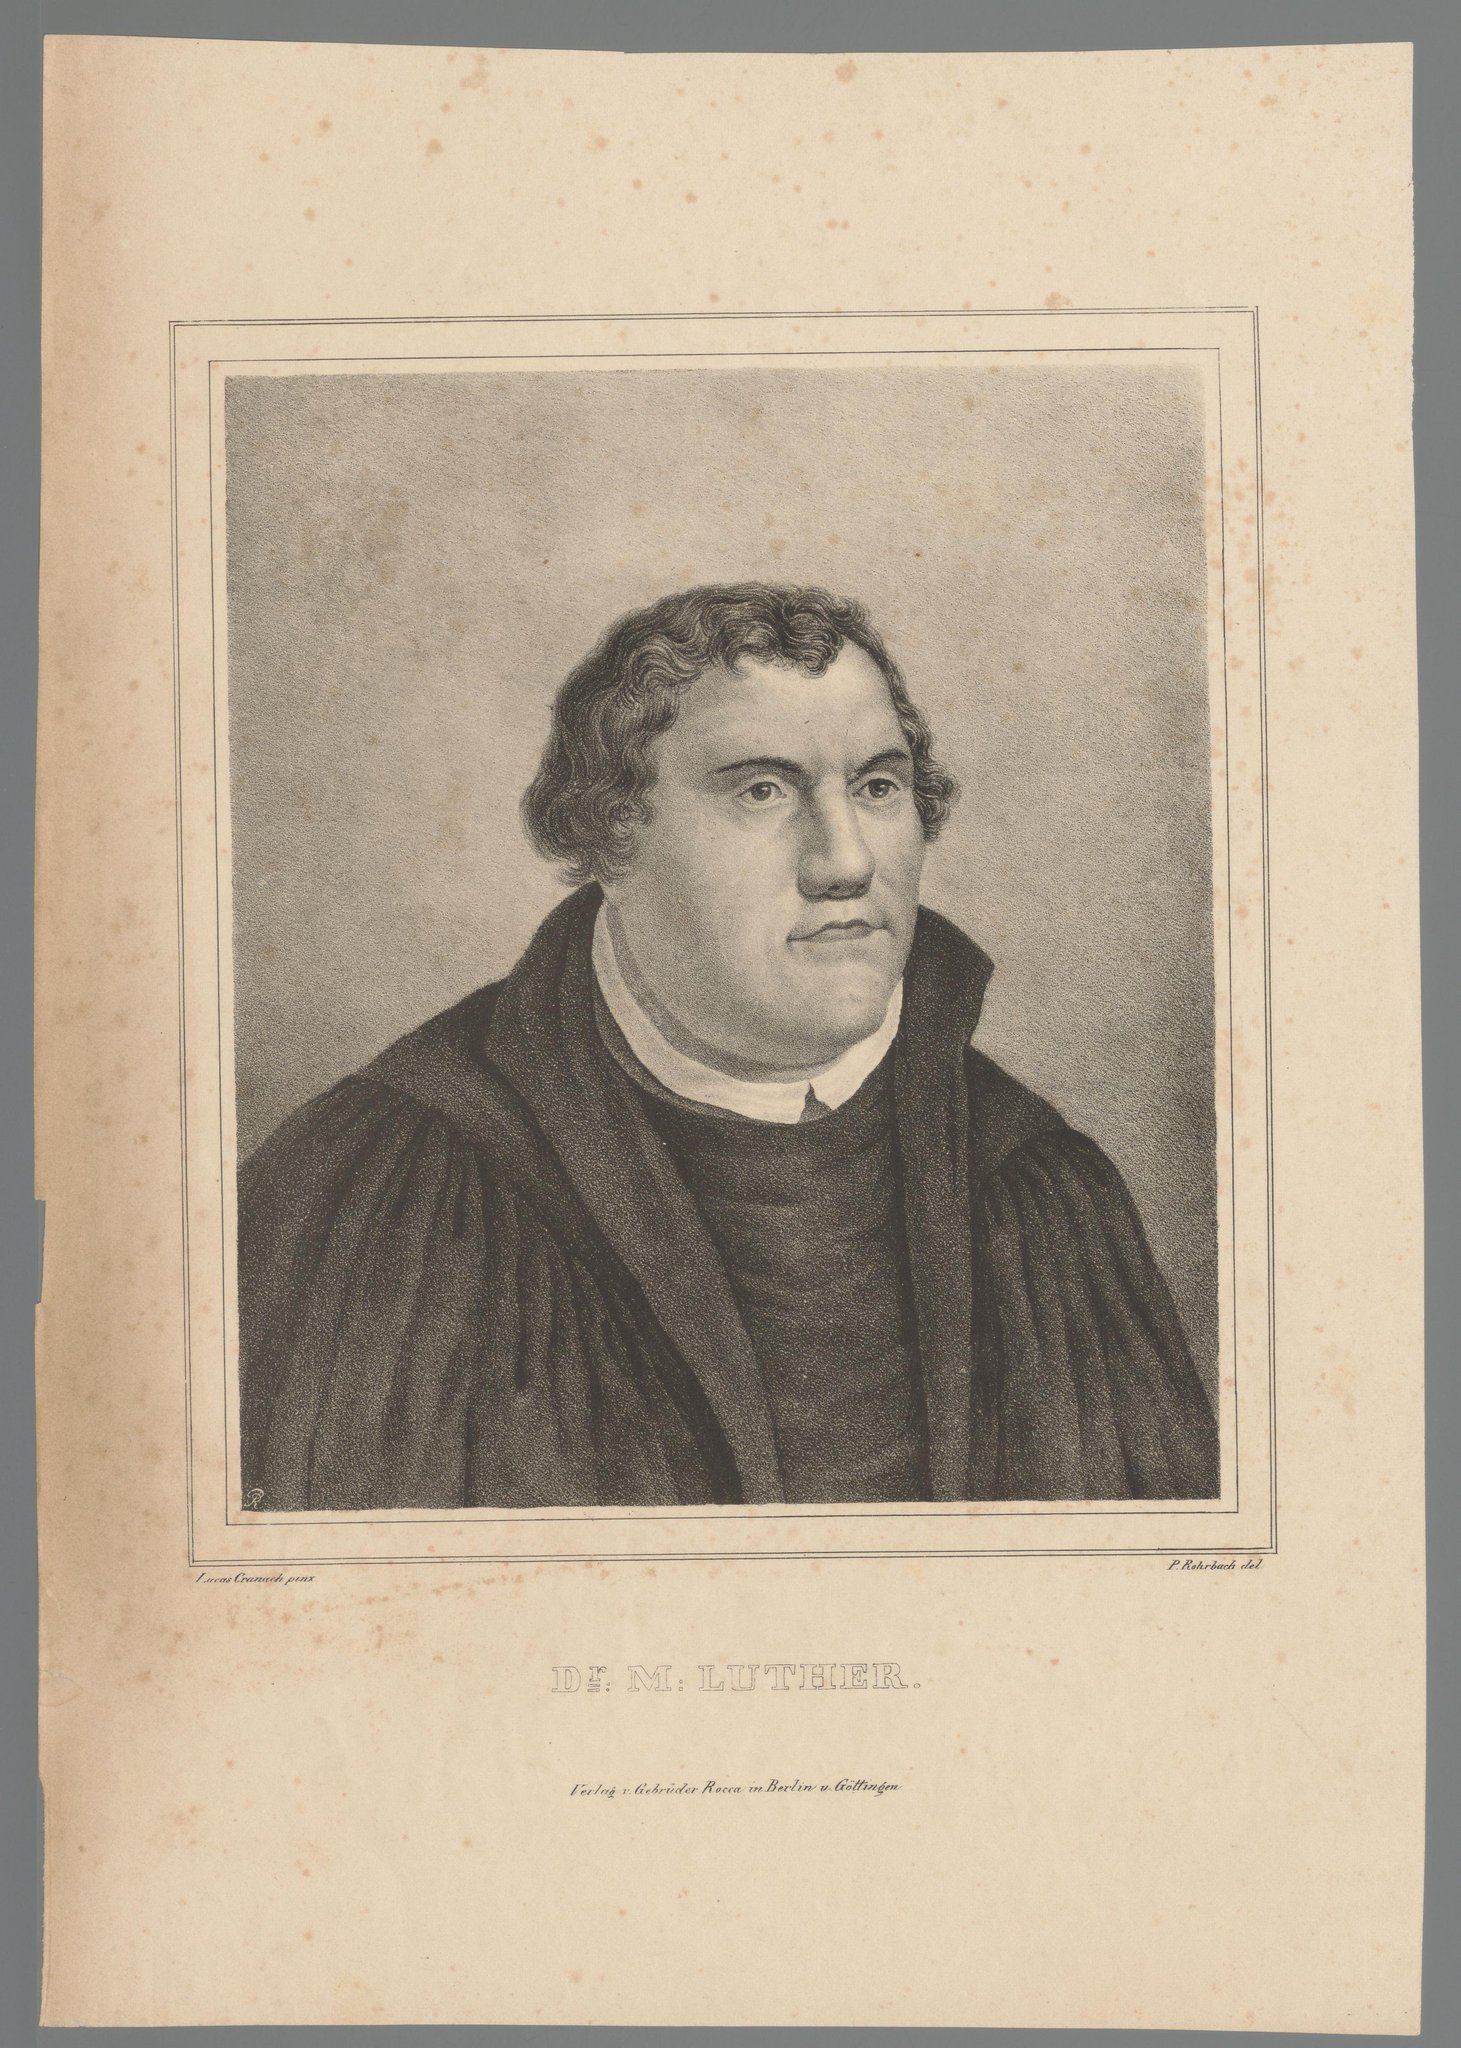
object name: print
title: Portret van Martin Luther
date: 1827-1862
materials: paper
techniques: lithograph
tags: priest, martin luther, theologian, historical persons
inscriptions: collector's mark: Lugt 2228